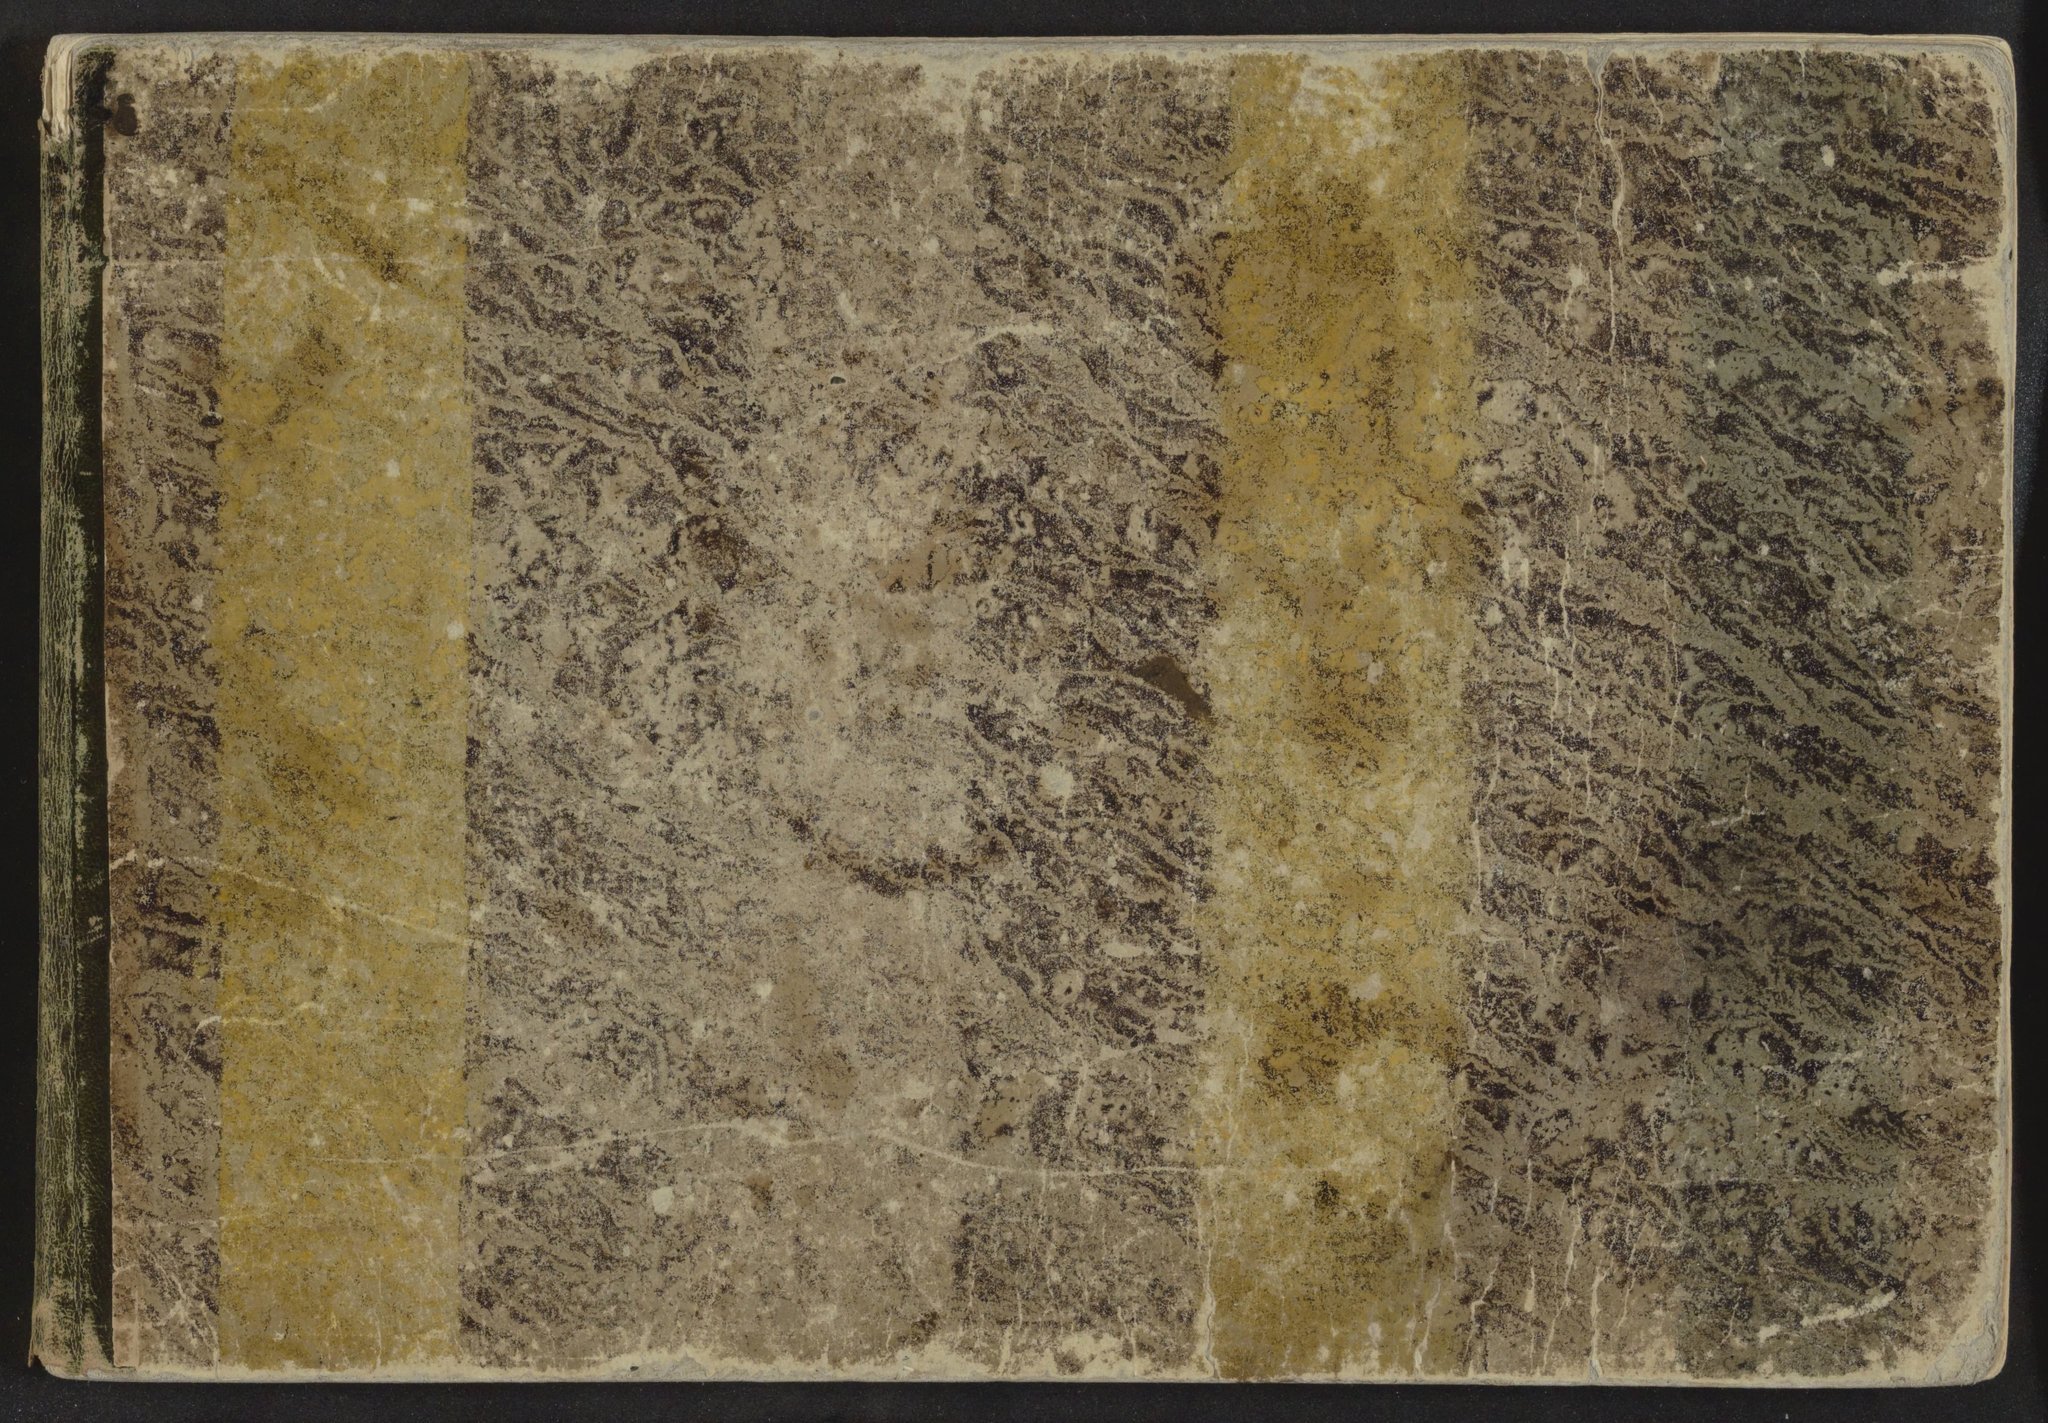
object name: sketchbook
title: Schetsboek met 45 bladen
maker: johannes tavenraat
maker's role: draughtsman, painter, print maker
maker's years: 1809-1881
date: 1842-1868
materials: cardboard, leather, paper, pencil, watercolor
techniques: brush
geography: chaam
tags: city-view, and landscape with man-made constructions, landscapes, farm (building), the hague, delft, nijmegen, cleves, gelderland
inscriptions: signature and date: ‘J. Tavenraat. Antwerpen / 1842.’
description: Schetsboek bestaande uit 45 bladen met studies van boerenwoningen, landschappen en stadsgezichten in Nederland en Kleef.